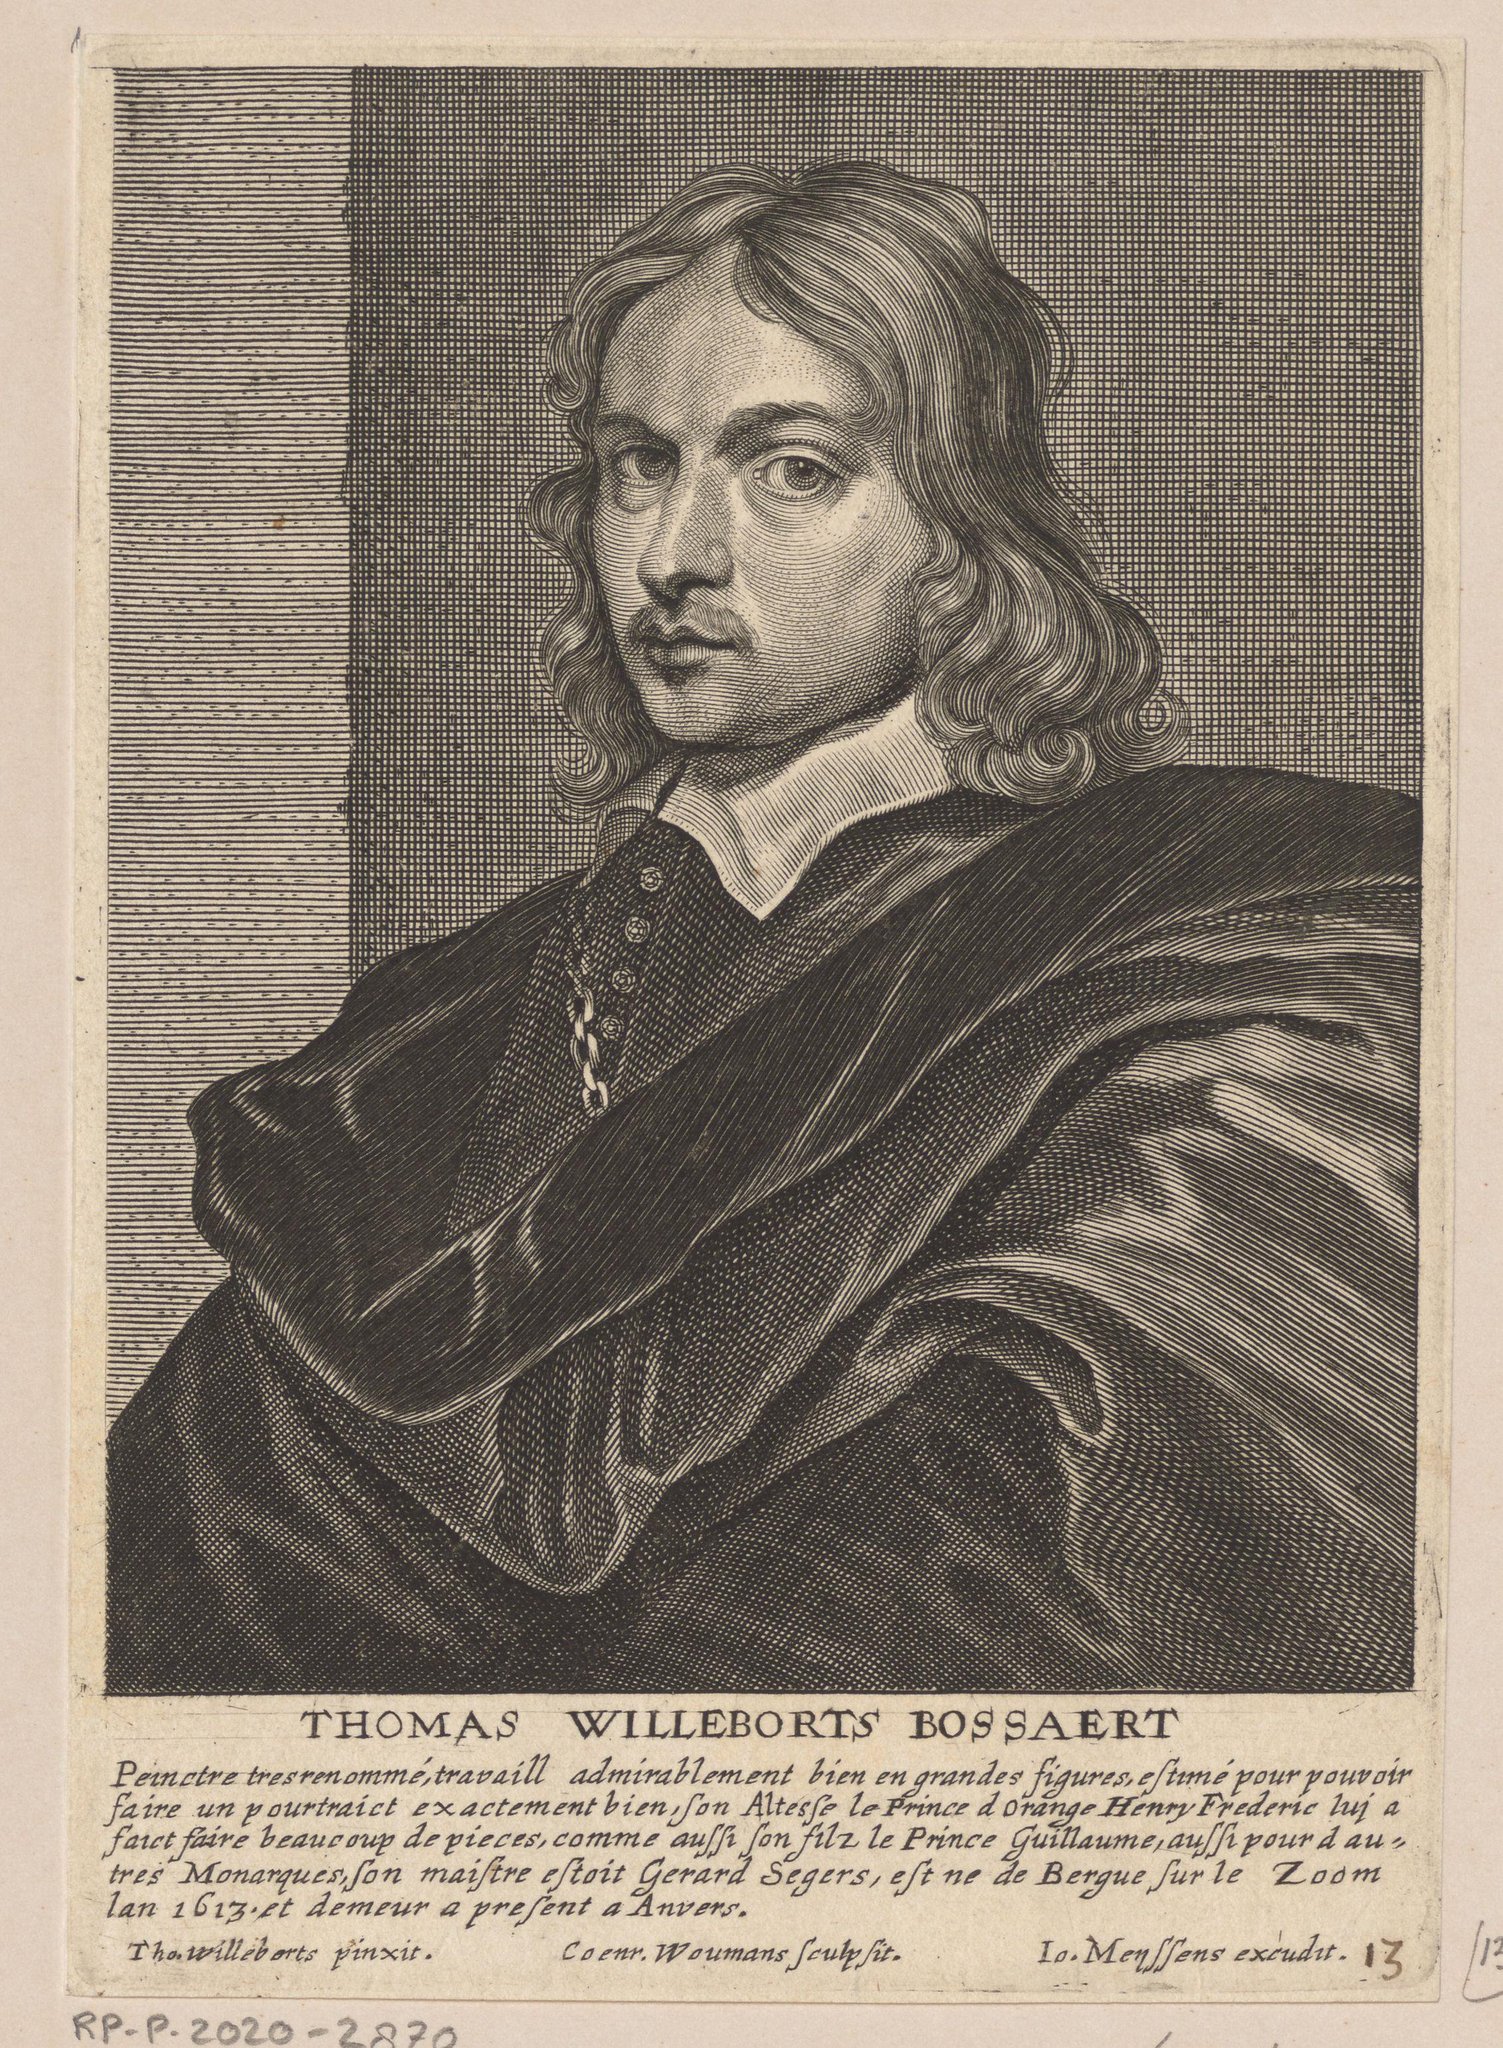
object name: print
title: Image de divers hommes desprit sublime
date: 1649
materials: paper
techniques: engraving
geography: antwerp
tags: bergen op zoom, antwerp, painter, draughtsman, thomas willeboirts bosschaert, historical persons, portrait, self-portrait of painter